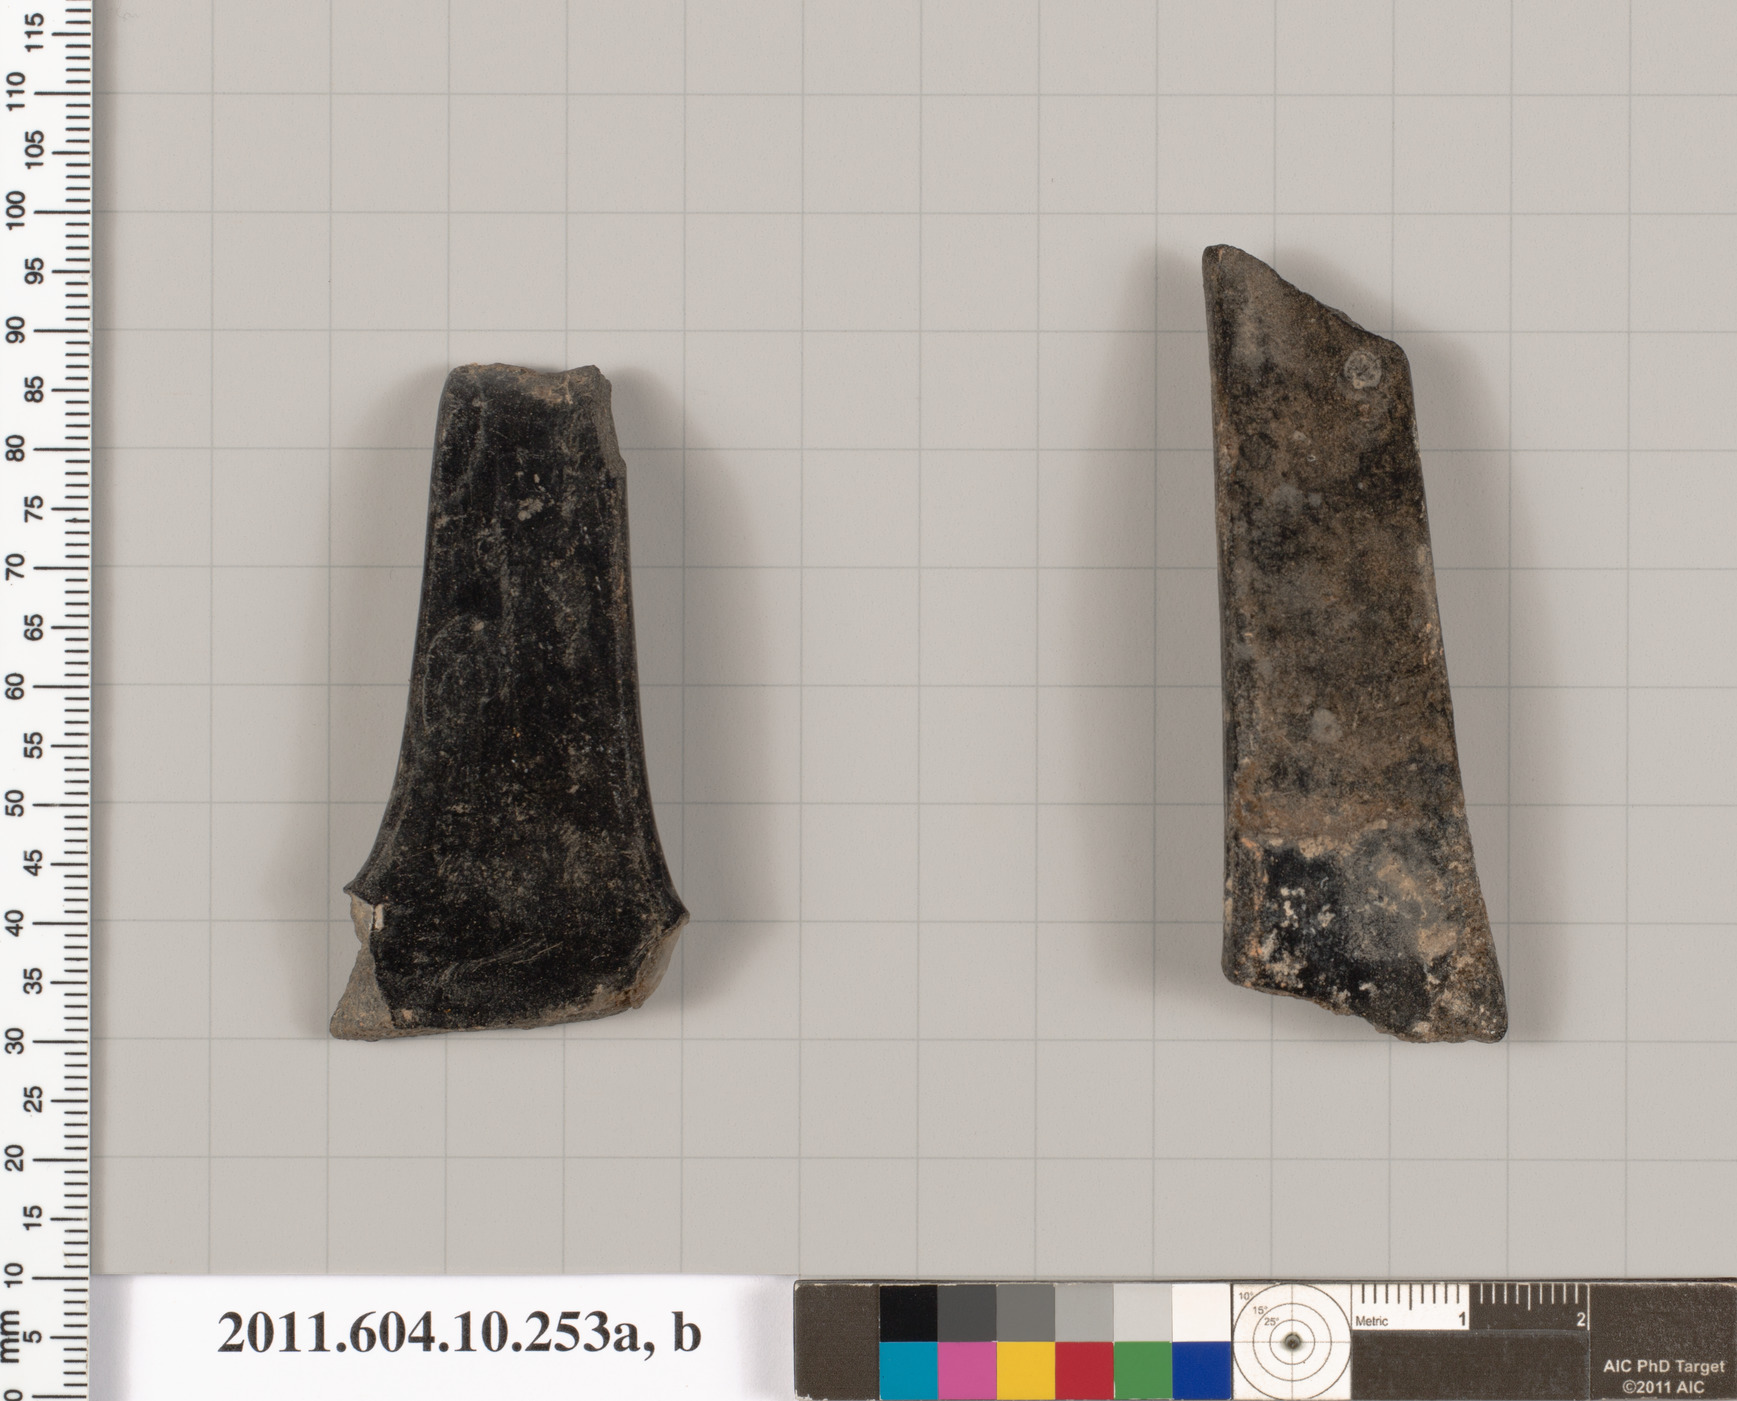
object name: kyathos fragment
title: Terracotta fragments from kyathoi (single handled cups)?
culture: etruscan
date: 534-468 BCE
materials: terracotta